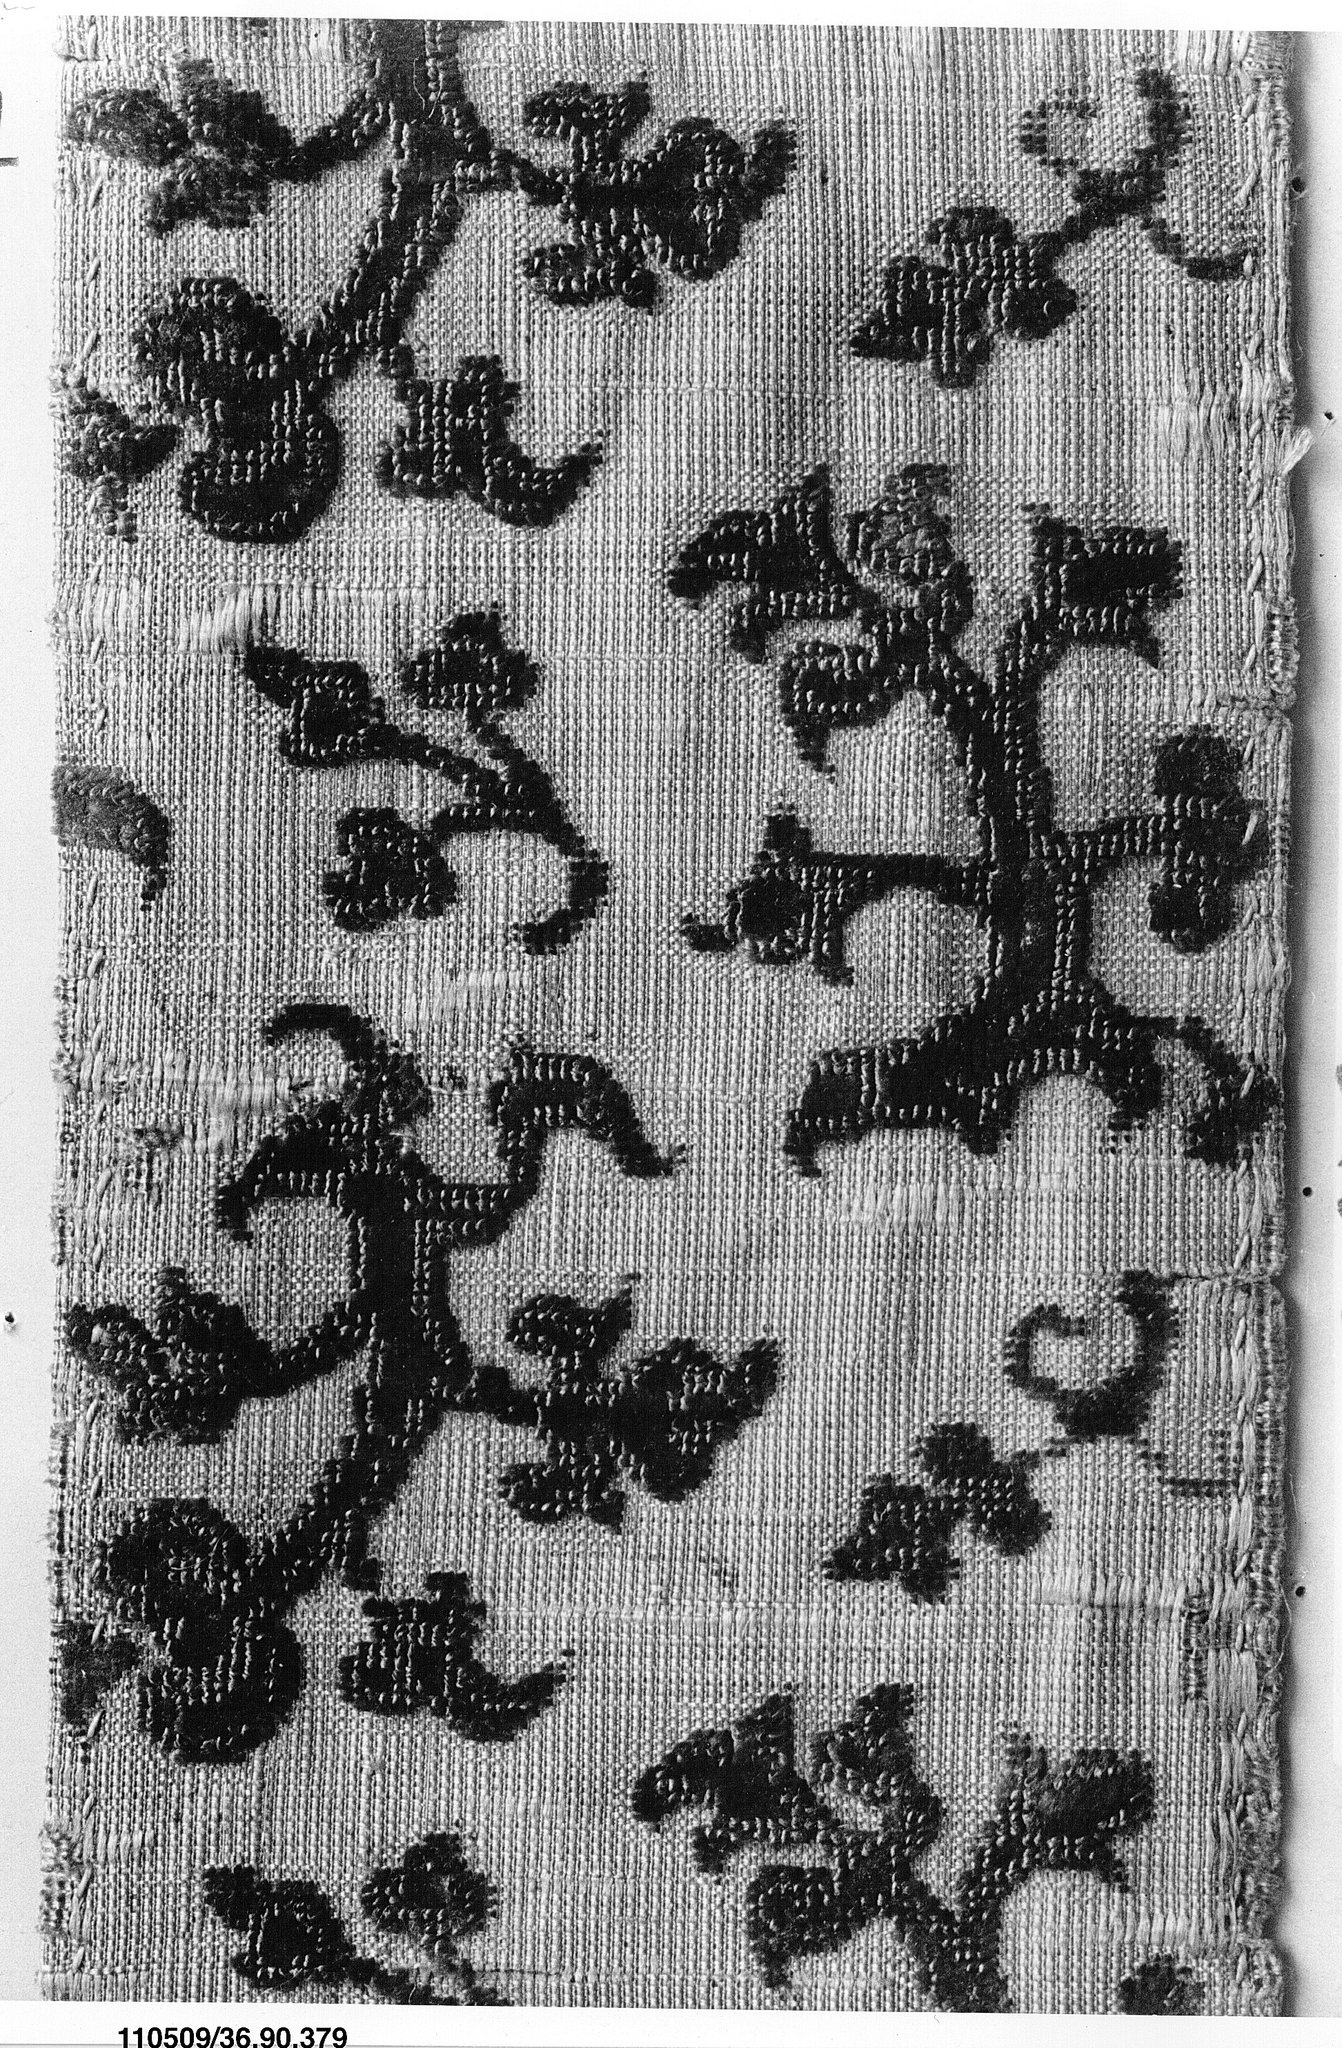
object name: piece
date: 1501-1700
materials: silk